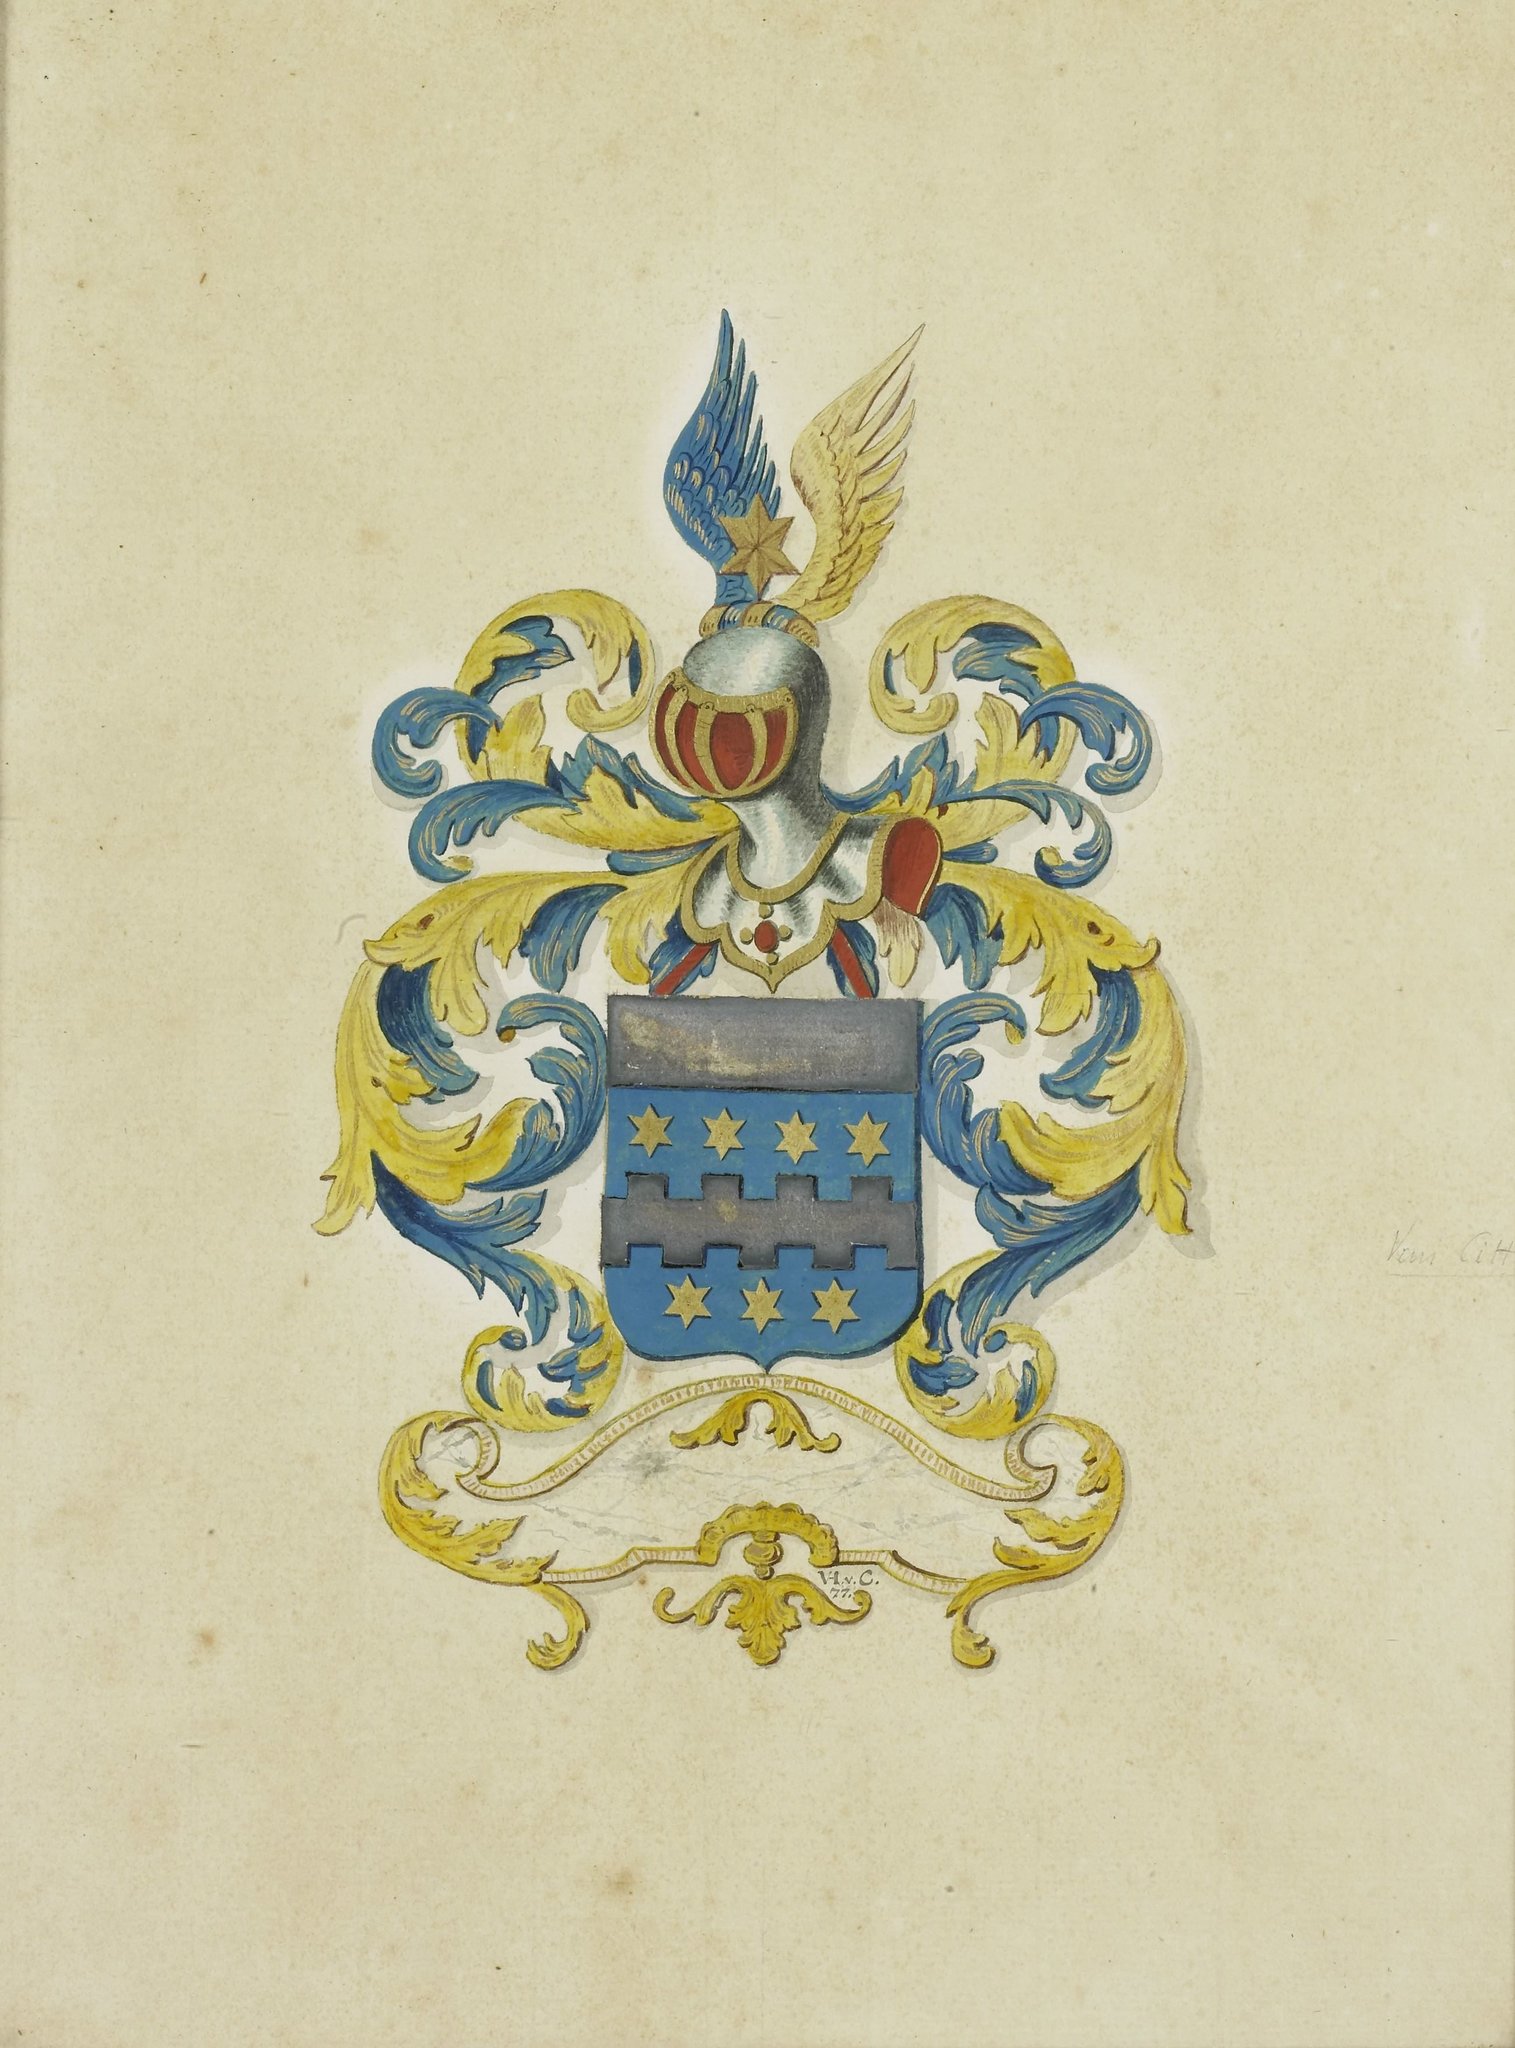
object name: heraldisch object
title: Het wapen van de familie van Citters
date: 1777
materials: paper, watercolor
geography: northern netherlands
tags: armorial bearing, heraldry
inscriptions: signature and date: ‘VHv.C. 77.’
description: Het wapen van de familie van Citters. Onderdeel van een reeks wapens behorend bij de schenking Jonkheer J. de Witte van Citters, Den Haag, 1876. Onderdeel van de collectie heraldische objecten.